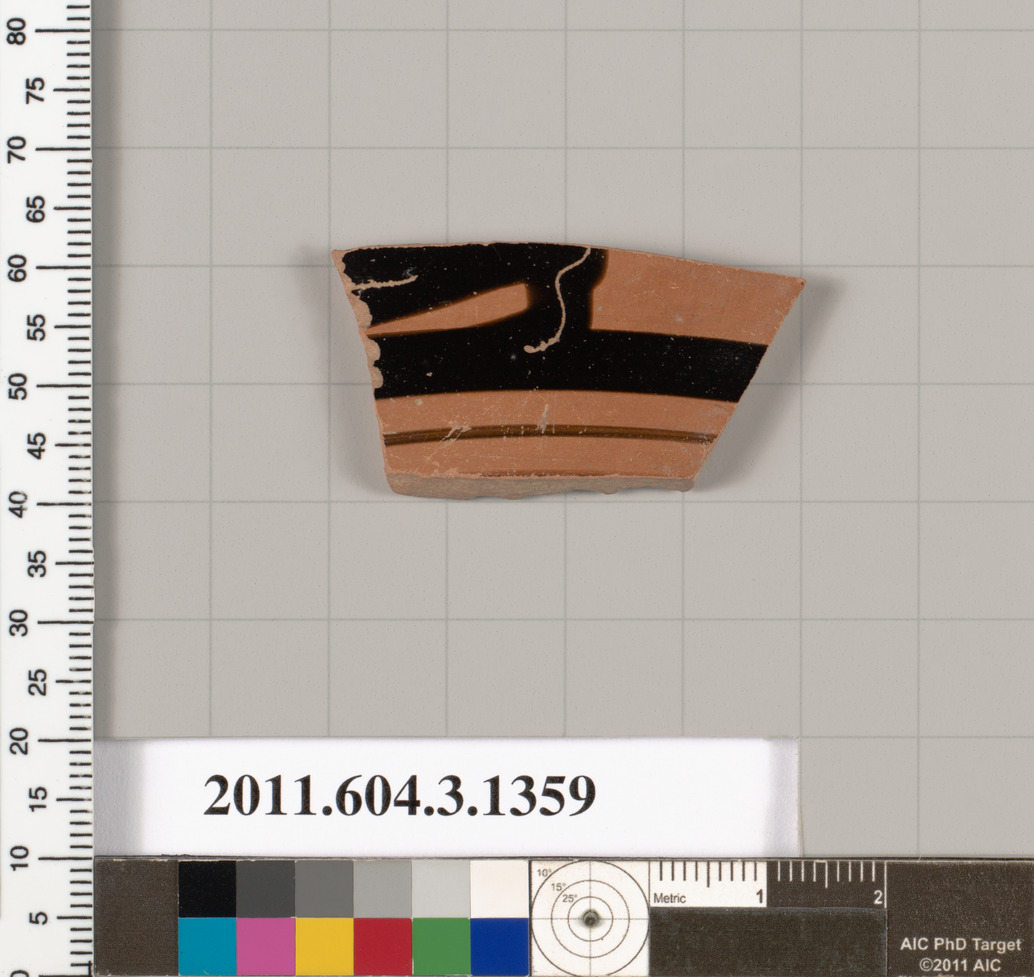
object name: skyphos fragment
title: Terracotta fragment of a skyphos (deep drinking cup)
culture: greek, attic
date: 500-468 BCE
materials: terracotta